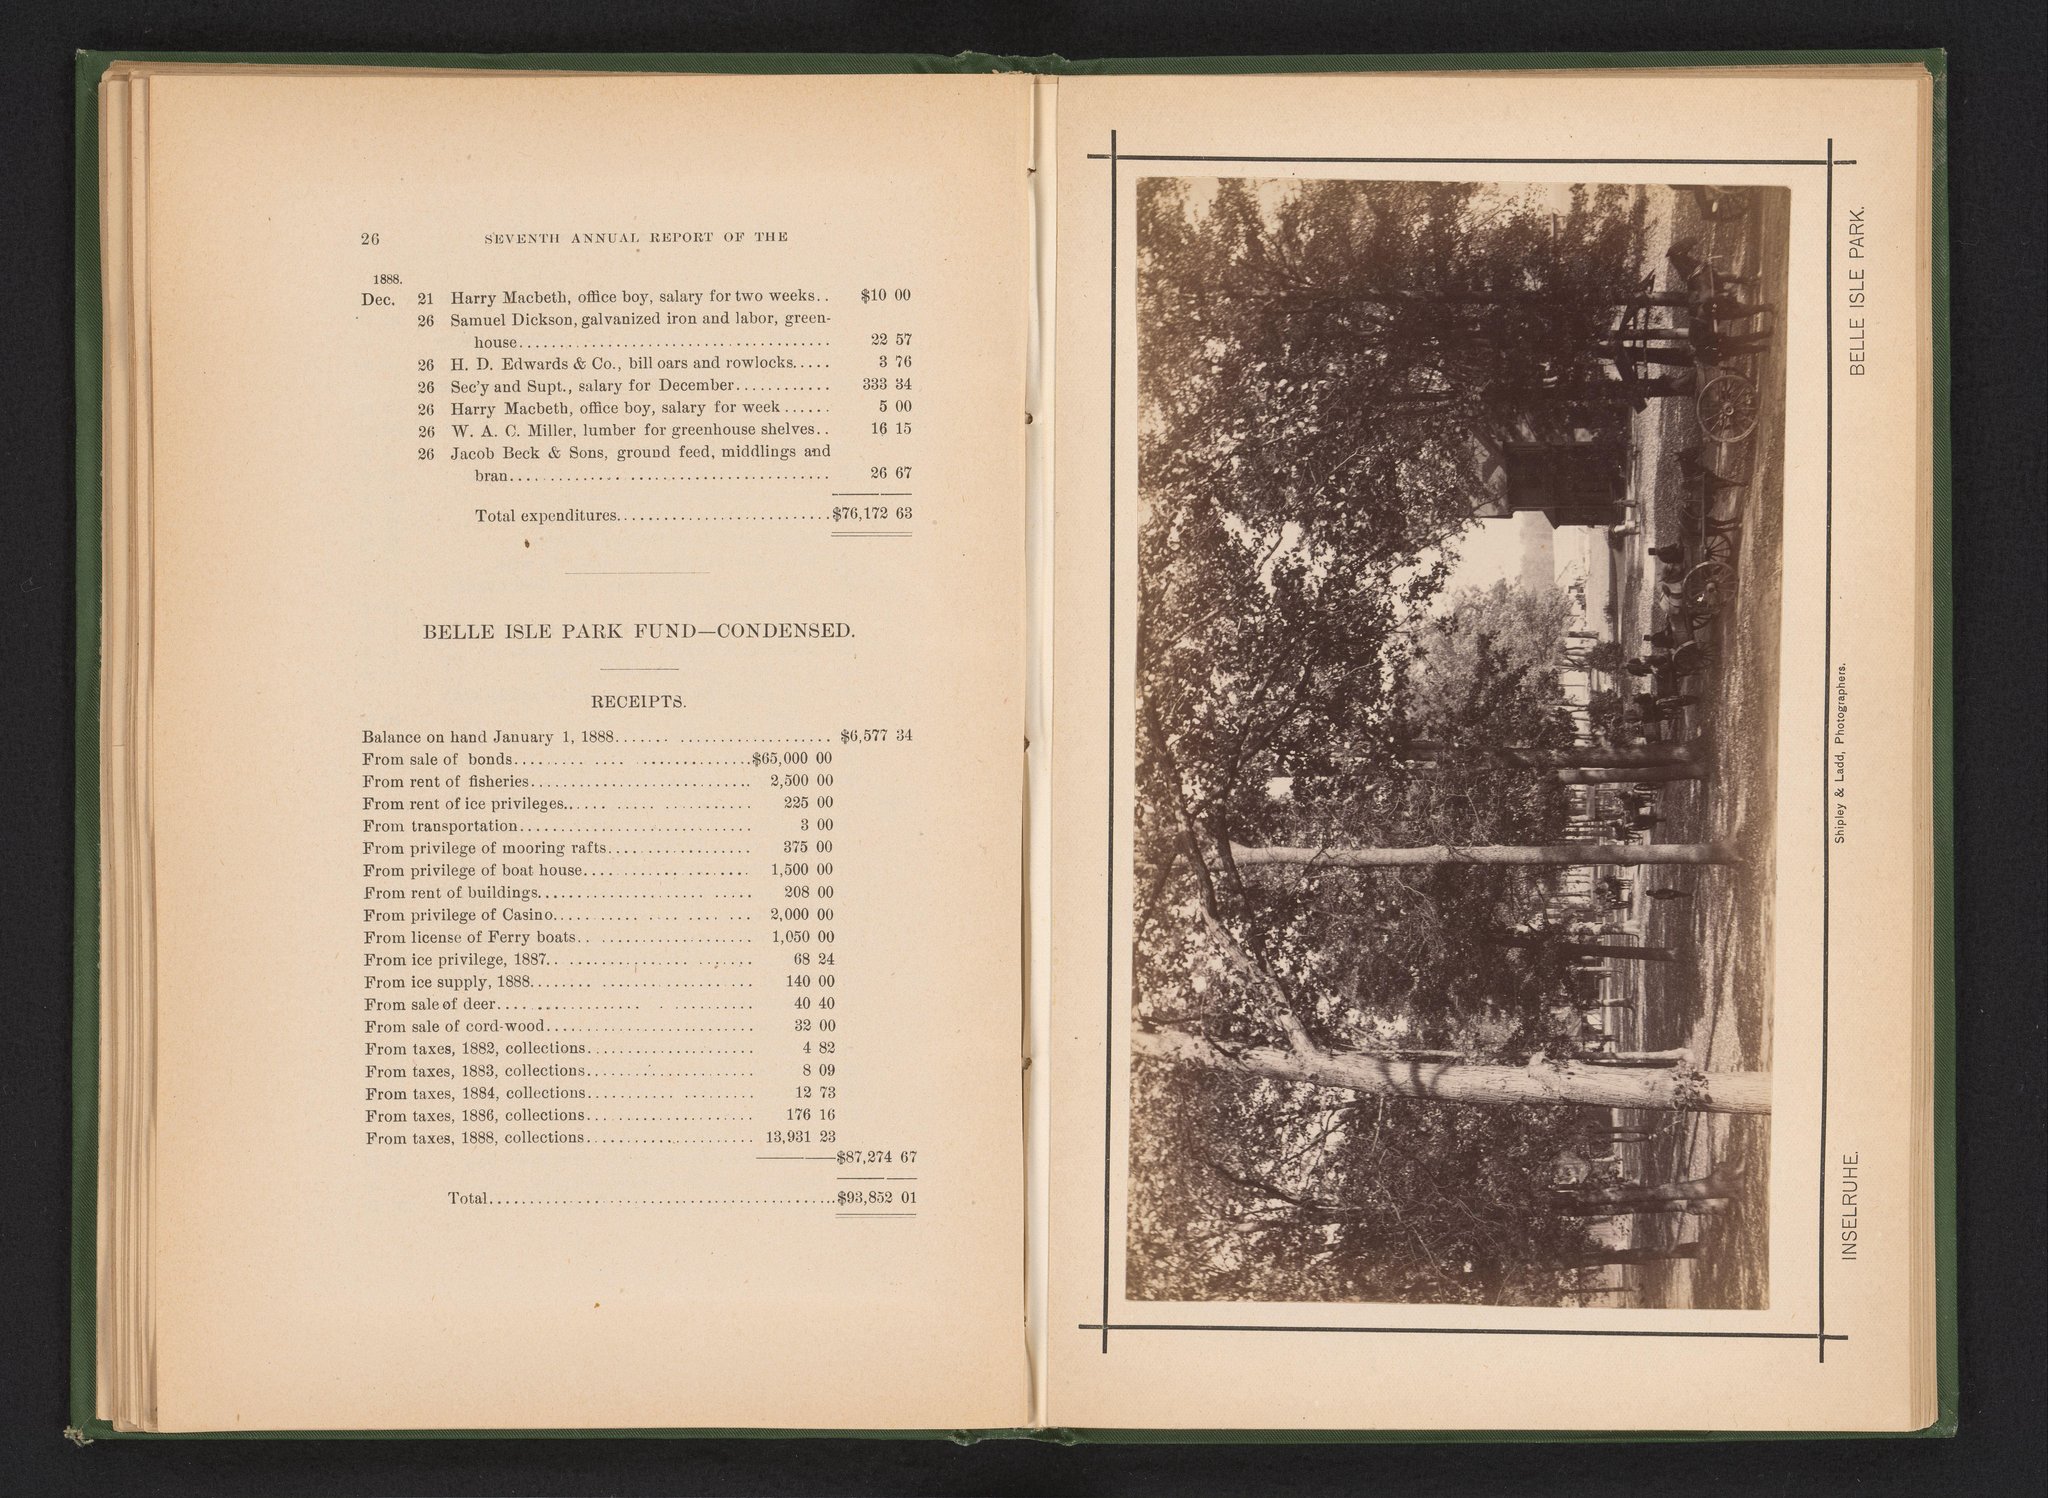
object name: photograph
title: Belle Isle Park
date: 1879-1889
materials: photographic support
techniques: albumen print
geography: belle isle park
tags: two-wheeled, animal-drawn vehicle, public road